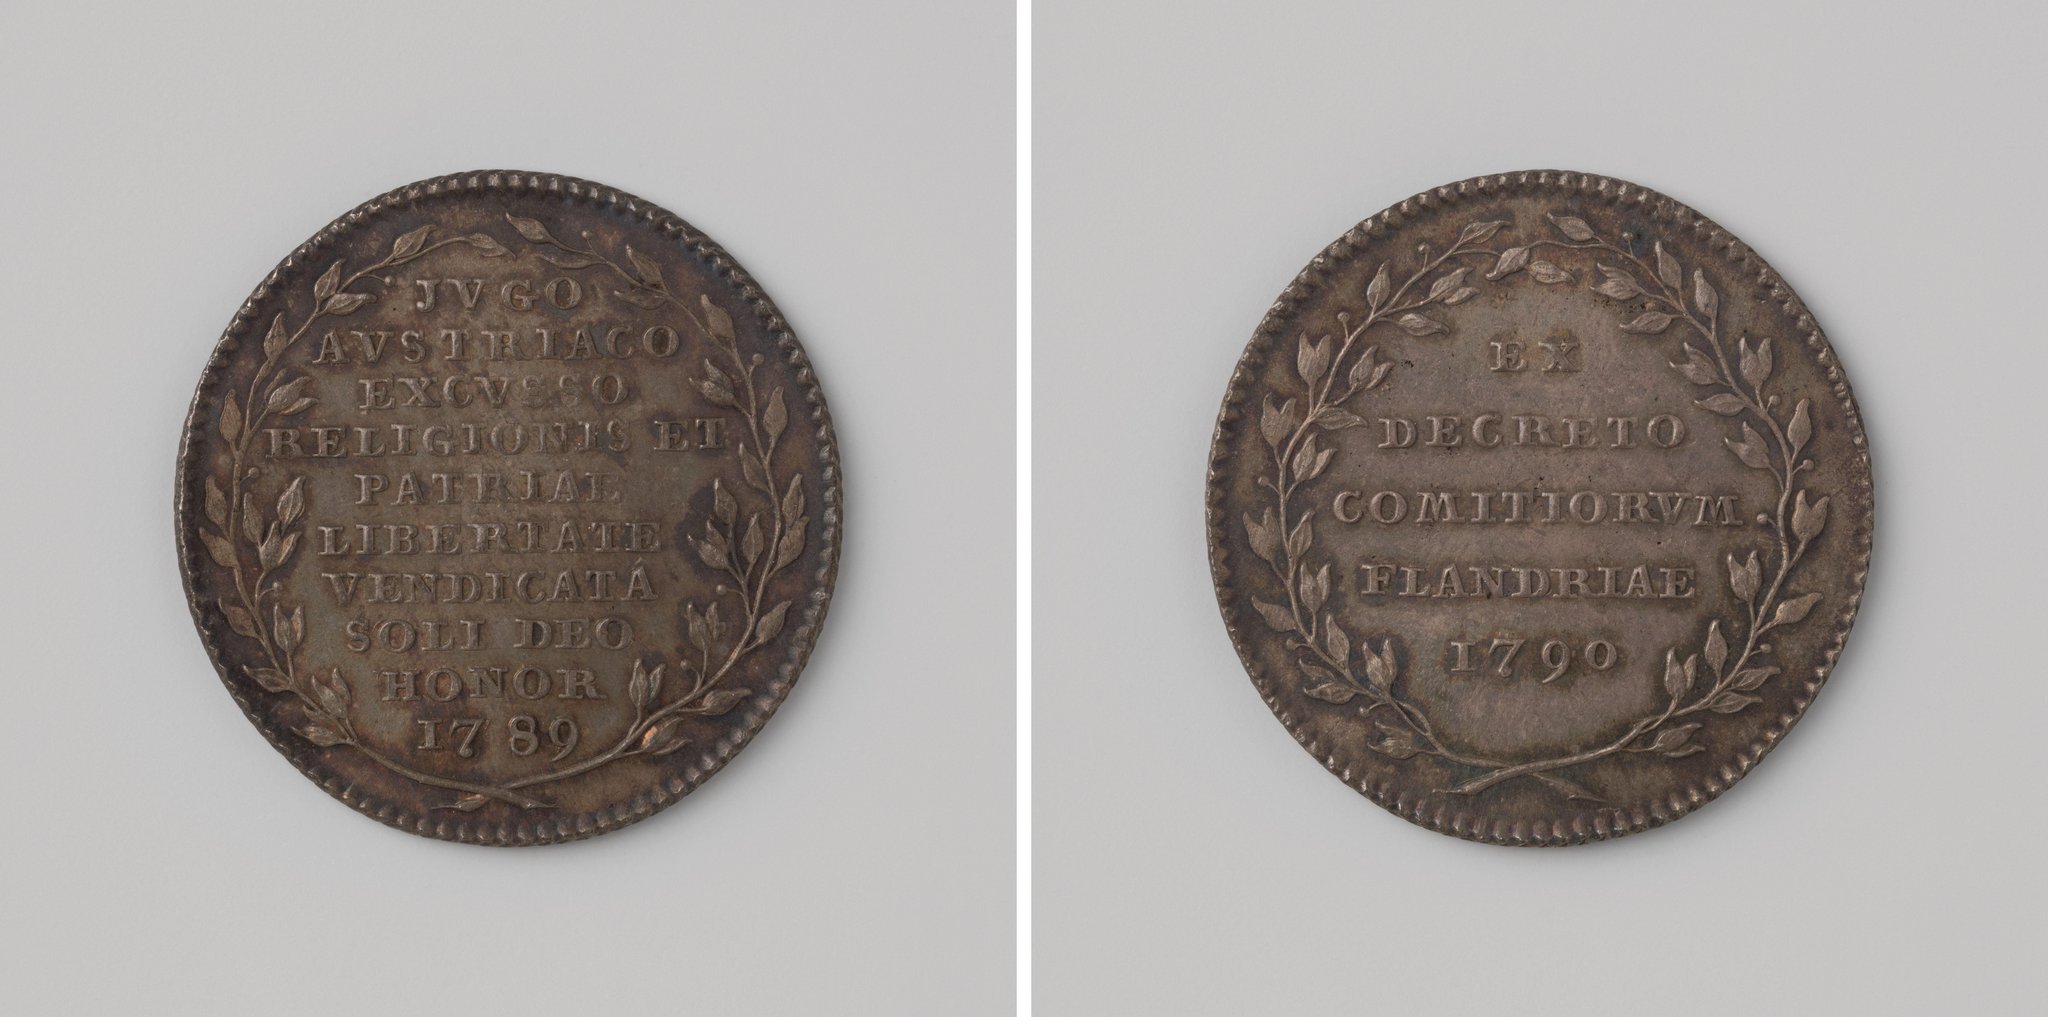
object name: history medal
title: Namen vrij verklaard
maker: Anonymous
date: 1790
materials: silver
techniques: striking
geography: namur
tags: namen (stad), brabantse omwenteling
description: Zilveren penning. Voorzijde: opschrift binnen lauwerkrans. Keerzijde: opschrift binnen lauwerkrans